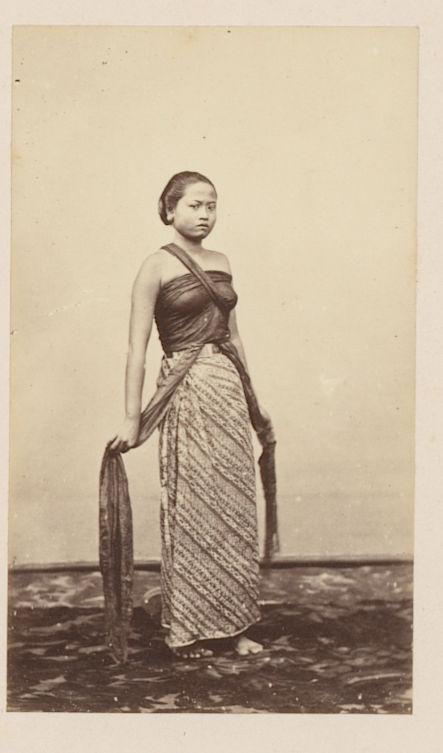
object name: photograph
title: Portret van een jonge Indonesische vrouw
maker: Anonymous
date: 1880-1883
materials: photographic support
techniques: albumen print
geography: dutch east indies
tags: adult woman, studio requisites ~ photographer, dutch east indies, the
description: Onderdeel van Reisalbum met opnames van bezienswaardigheden in Egypte, Nederlands-Indië, Singapore en Ceylon.